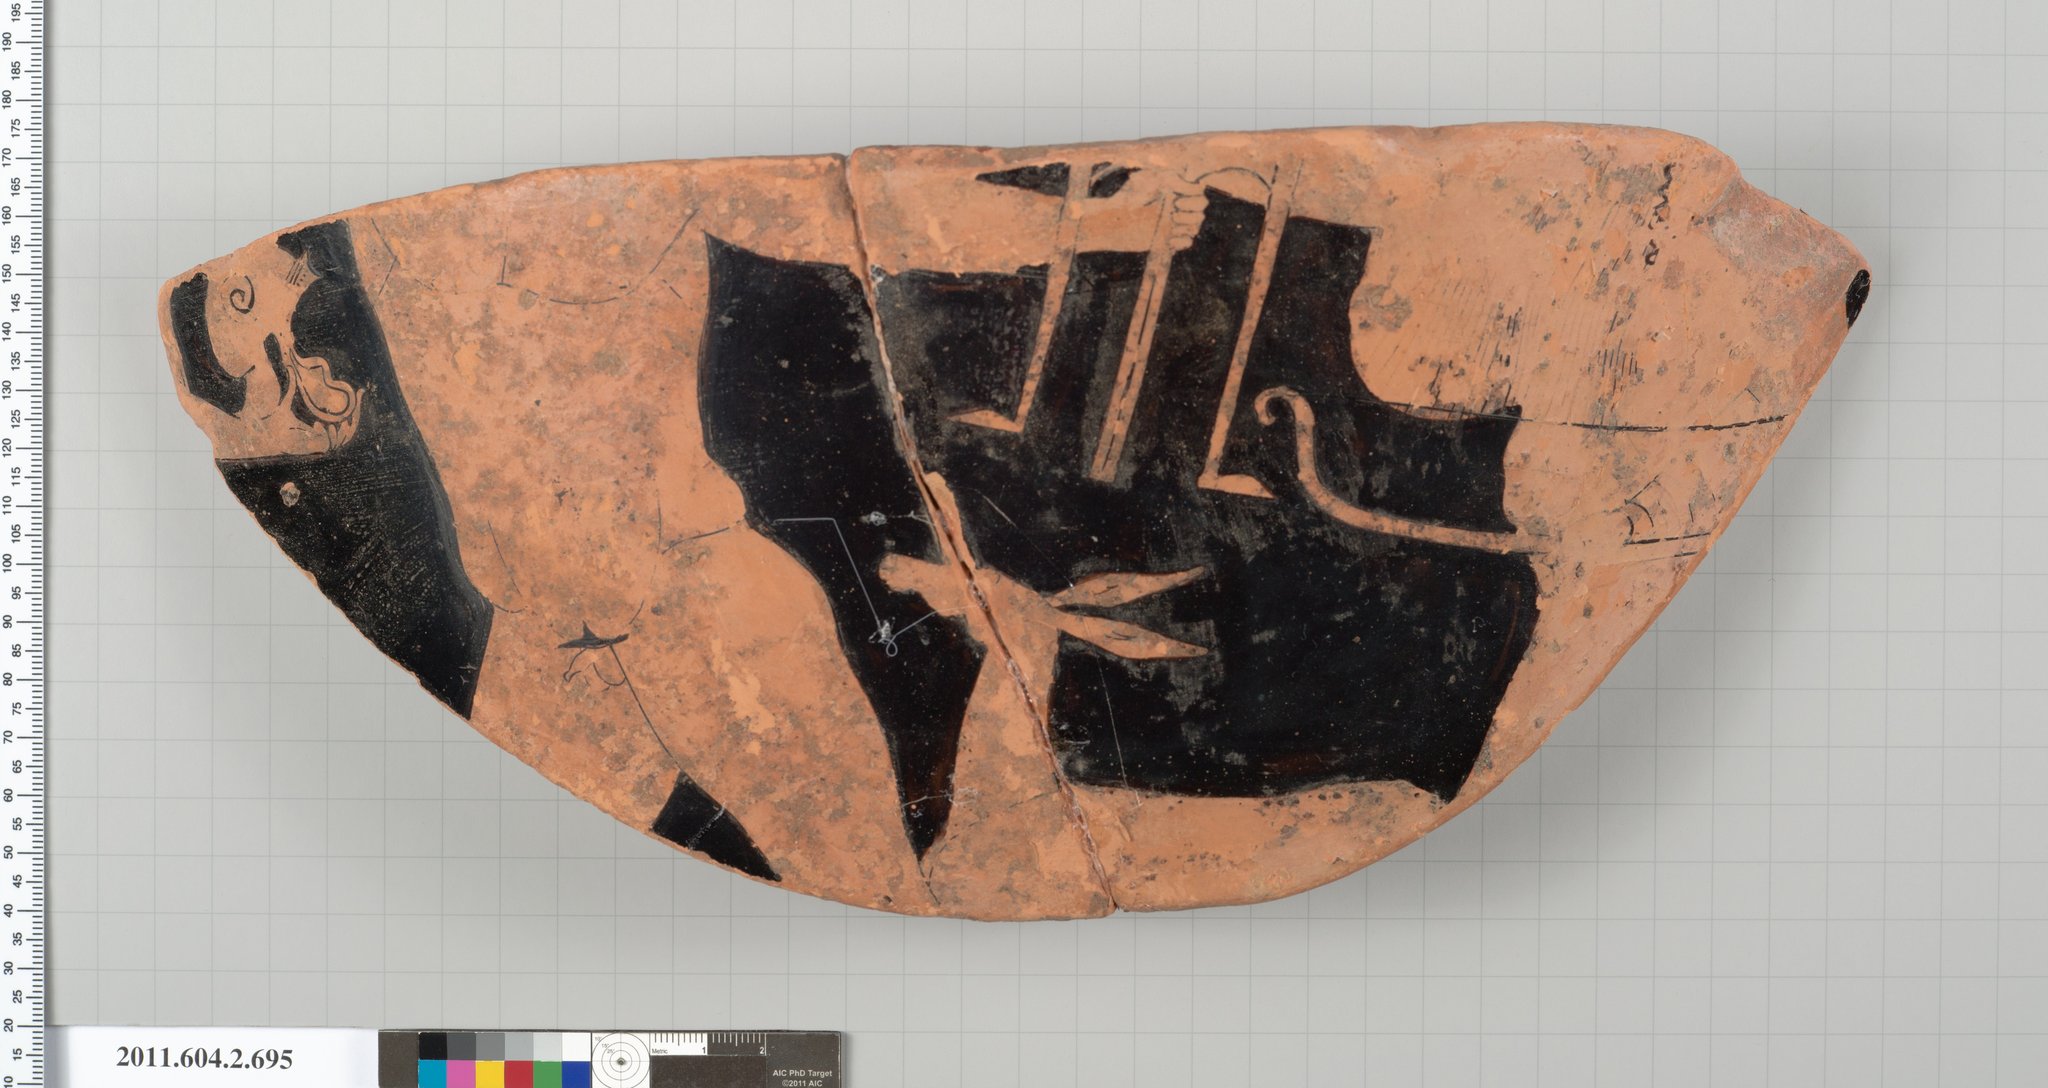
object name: calyx krater fragment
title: Terracotta fragment of a calyx-krater (bowl for mixing wine and water)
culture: greek, attic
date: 490-470 BCE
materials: terracotta